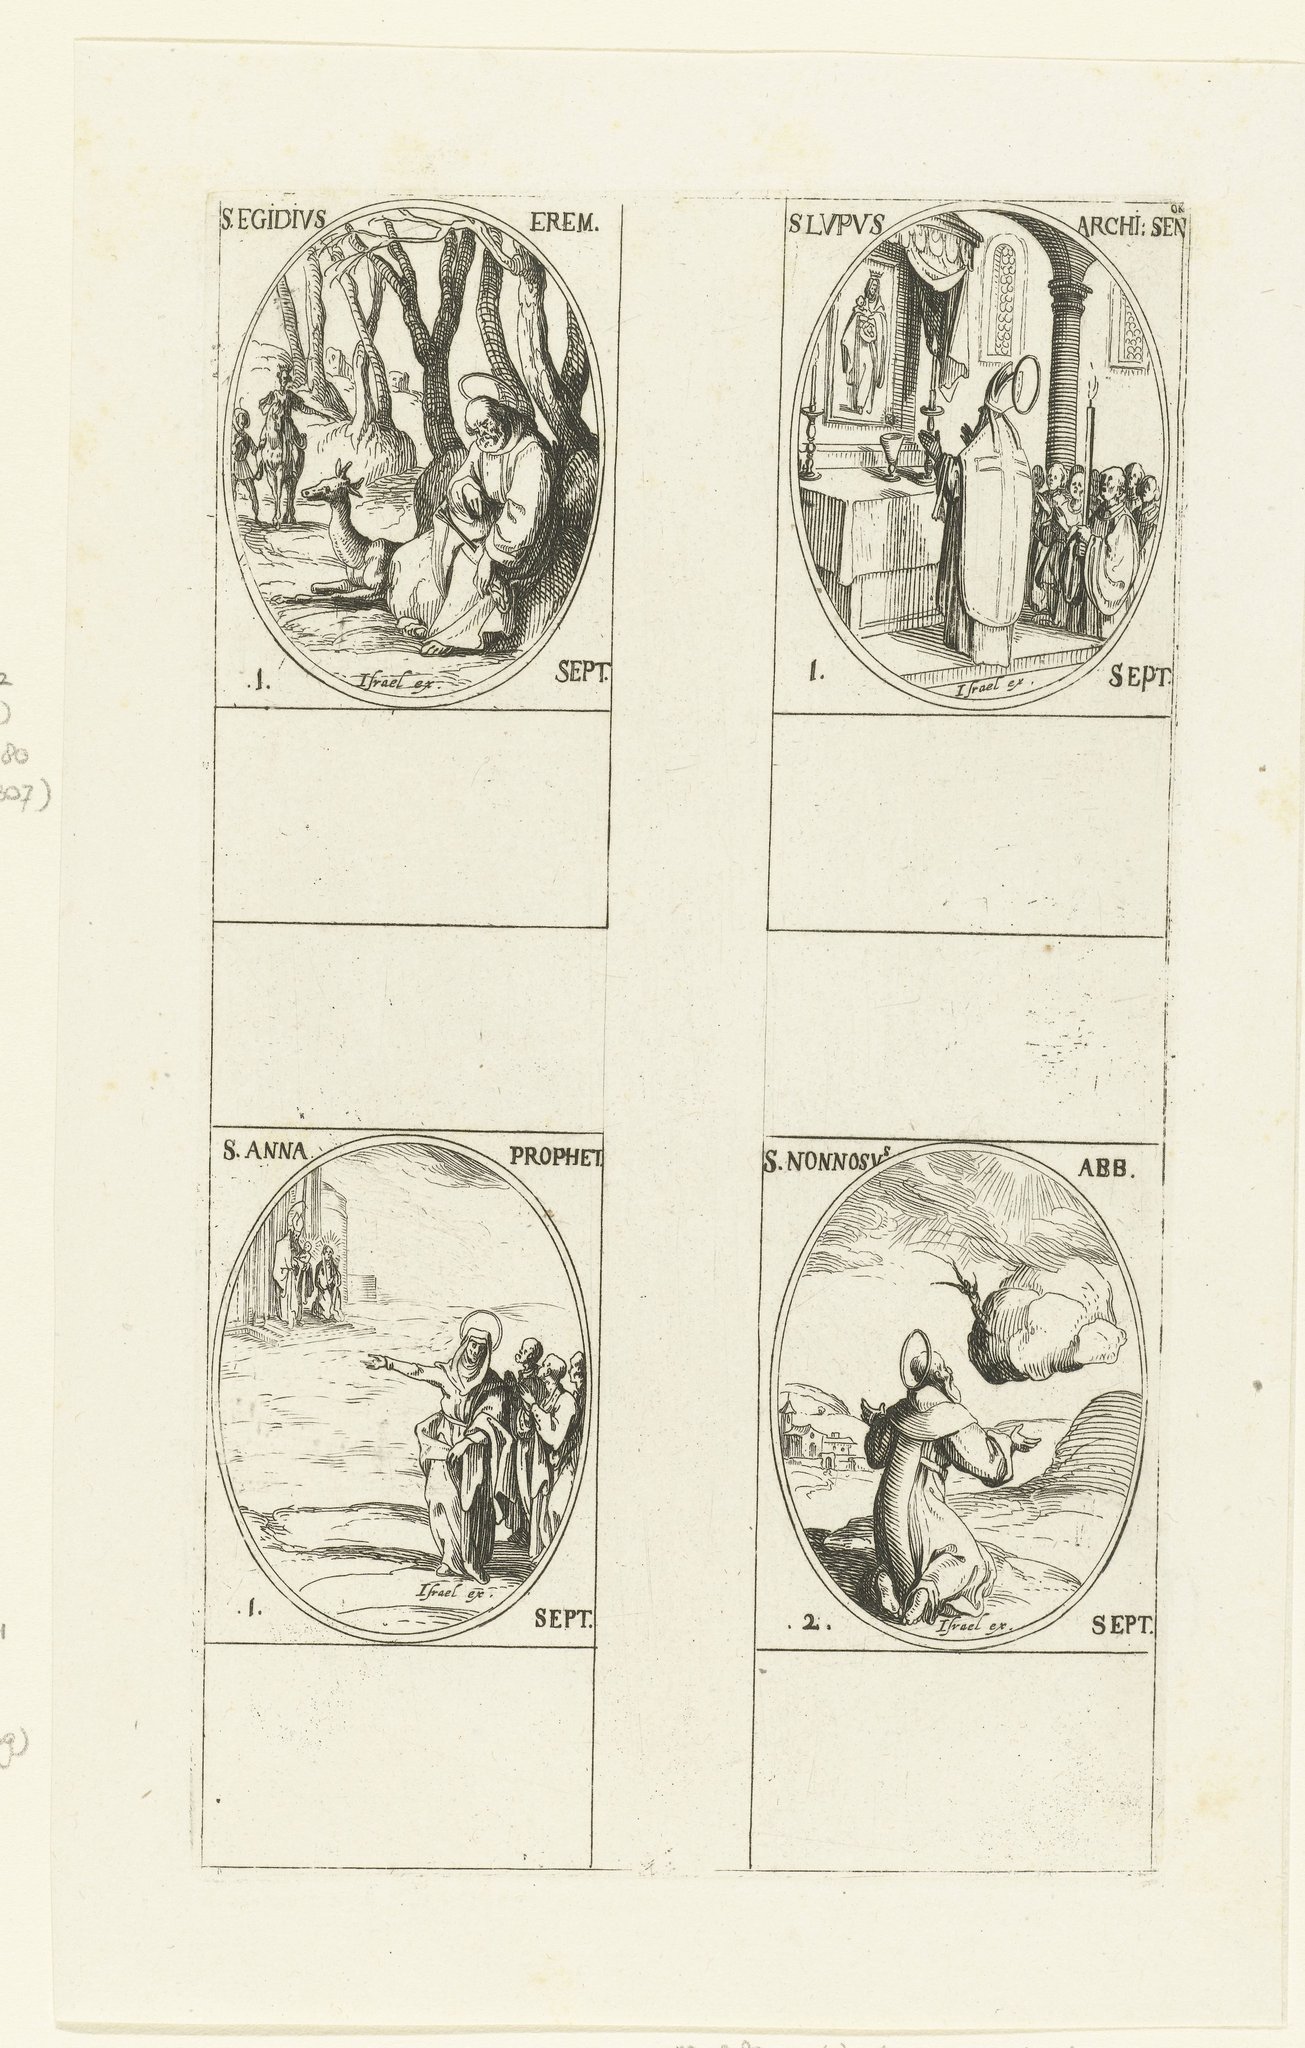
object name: print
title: Heilige Aegidius van Nîmes, Heilige Lupus van Sens, Heilige profetes Anna, Heilige Nonnosus van Soracte (1-2 september)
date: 1632-1636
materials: paper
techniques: etching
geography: paris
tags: male saints (with name), anna prophesying ~ presentation of the christ-child, the king of the visigoths, out hunting, finds st. giles in his retreat in the woods; giles protects a stag in his arms, and an arrow pierces his hand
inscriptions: collector's mark: Lugt 240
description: Blad met vier ovale voorstellingen, elk met opschrift en datum in het Latijn: linksboven de Heilige Aegidius van Nîmes zittend naast een hinde in een bos, rechtsboven de Heilige Lupus van Sens voor een altaar waarop een kelk staat waarin juist een edelsteen valt, linksonder de Heilige profetes Anna die een groepje mannen wijst op Maria, een bisschop en het Christuskind, rechtsonder de Heilige Nonnosus van Soracte geknield voor een zwevend blok steen waaruit een tak groeit. Deze prent is onderdeel van een serie prenten met voorstellingen van de heiligen en de christelijke feestdagen van het jaar. Er zijn steeds vier scènes van één plaat op één blad gedrukt. Inclusief bijbehorend titelblad en frontispice gaat het in totaal om 124 platen (490 voorstellingen). De drie platen met de laatste 12 scènes (de veranderlijke christelijke feestdagen) zijn in de derde staat versneden tot 12 kleine plaatjes, en met een apart titelblad uitgegeven.